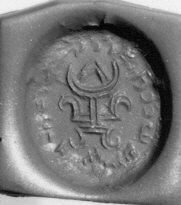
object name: stamp seal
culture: sasanian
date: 401-600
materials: marble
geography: iran or mesopotamia